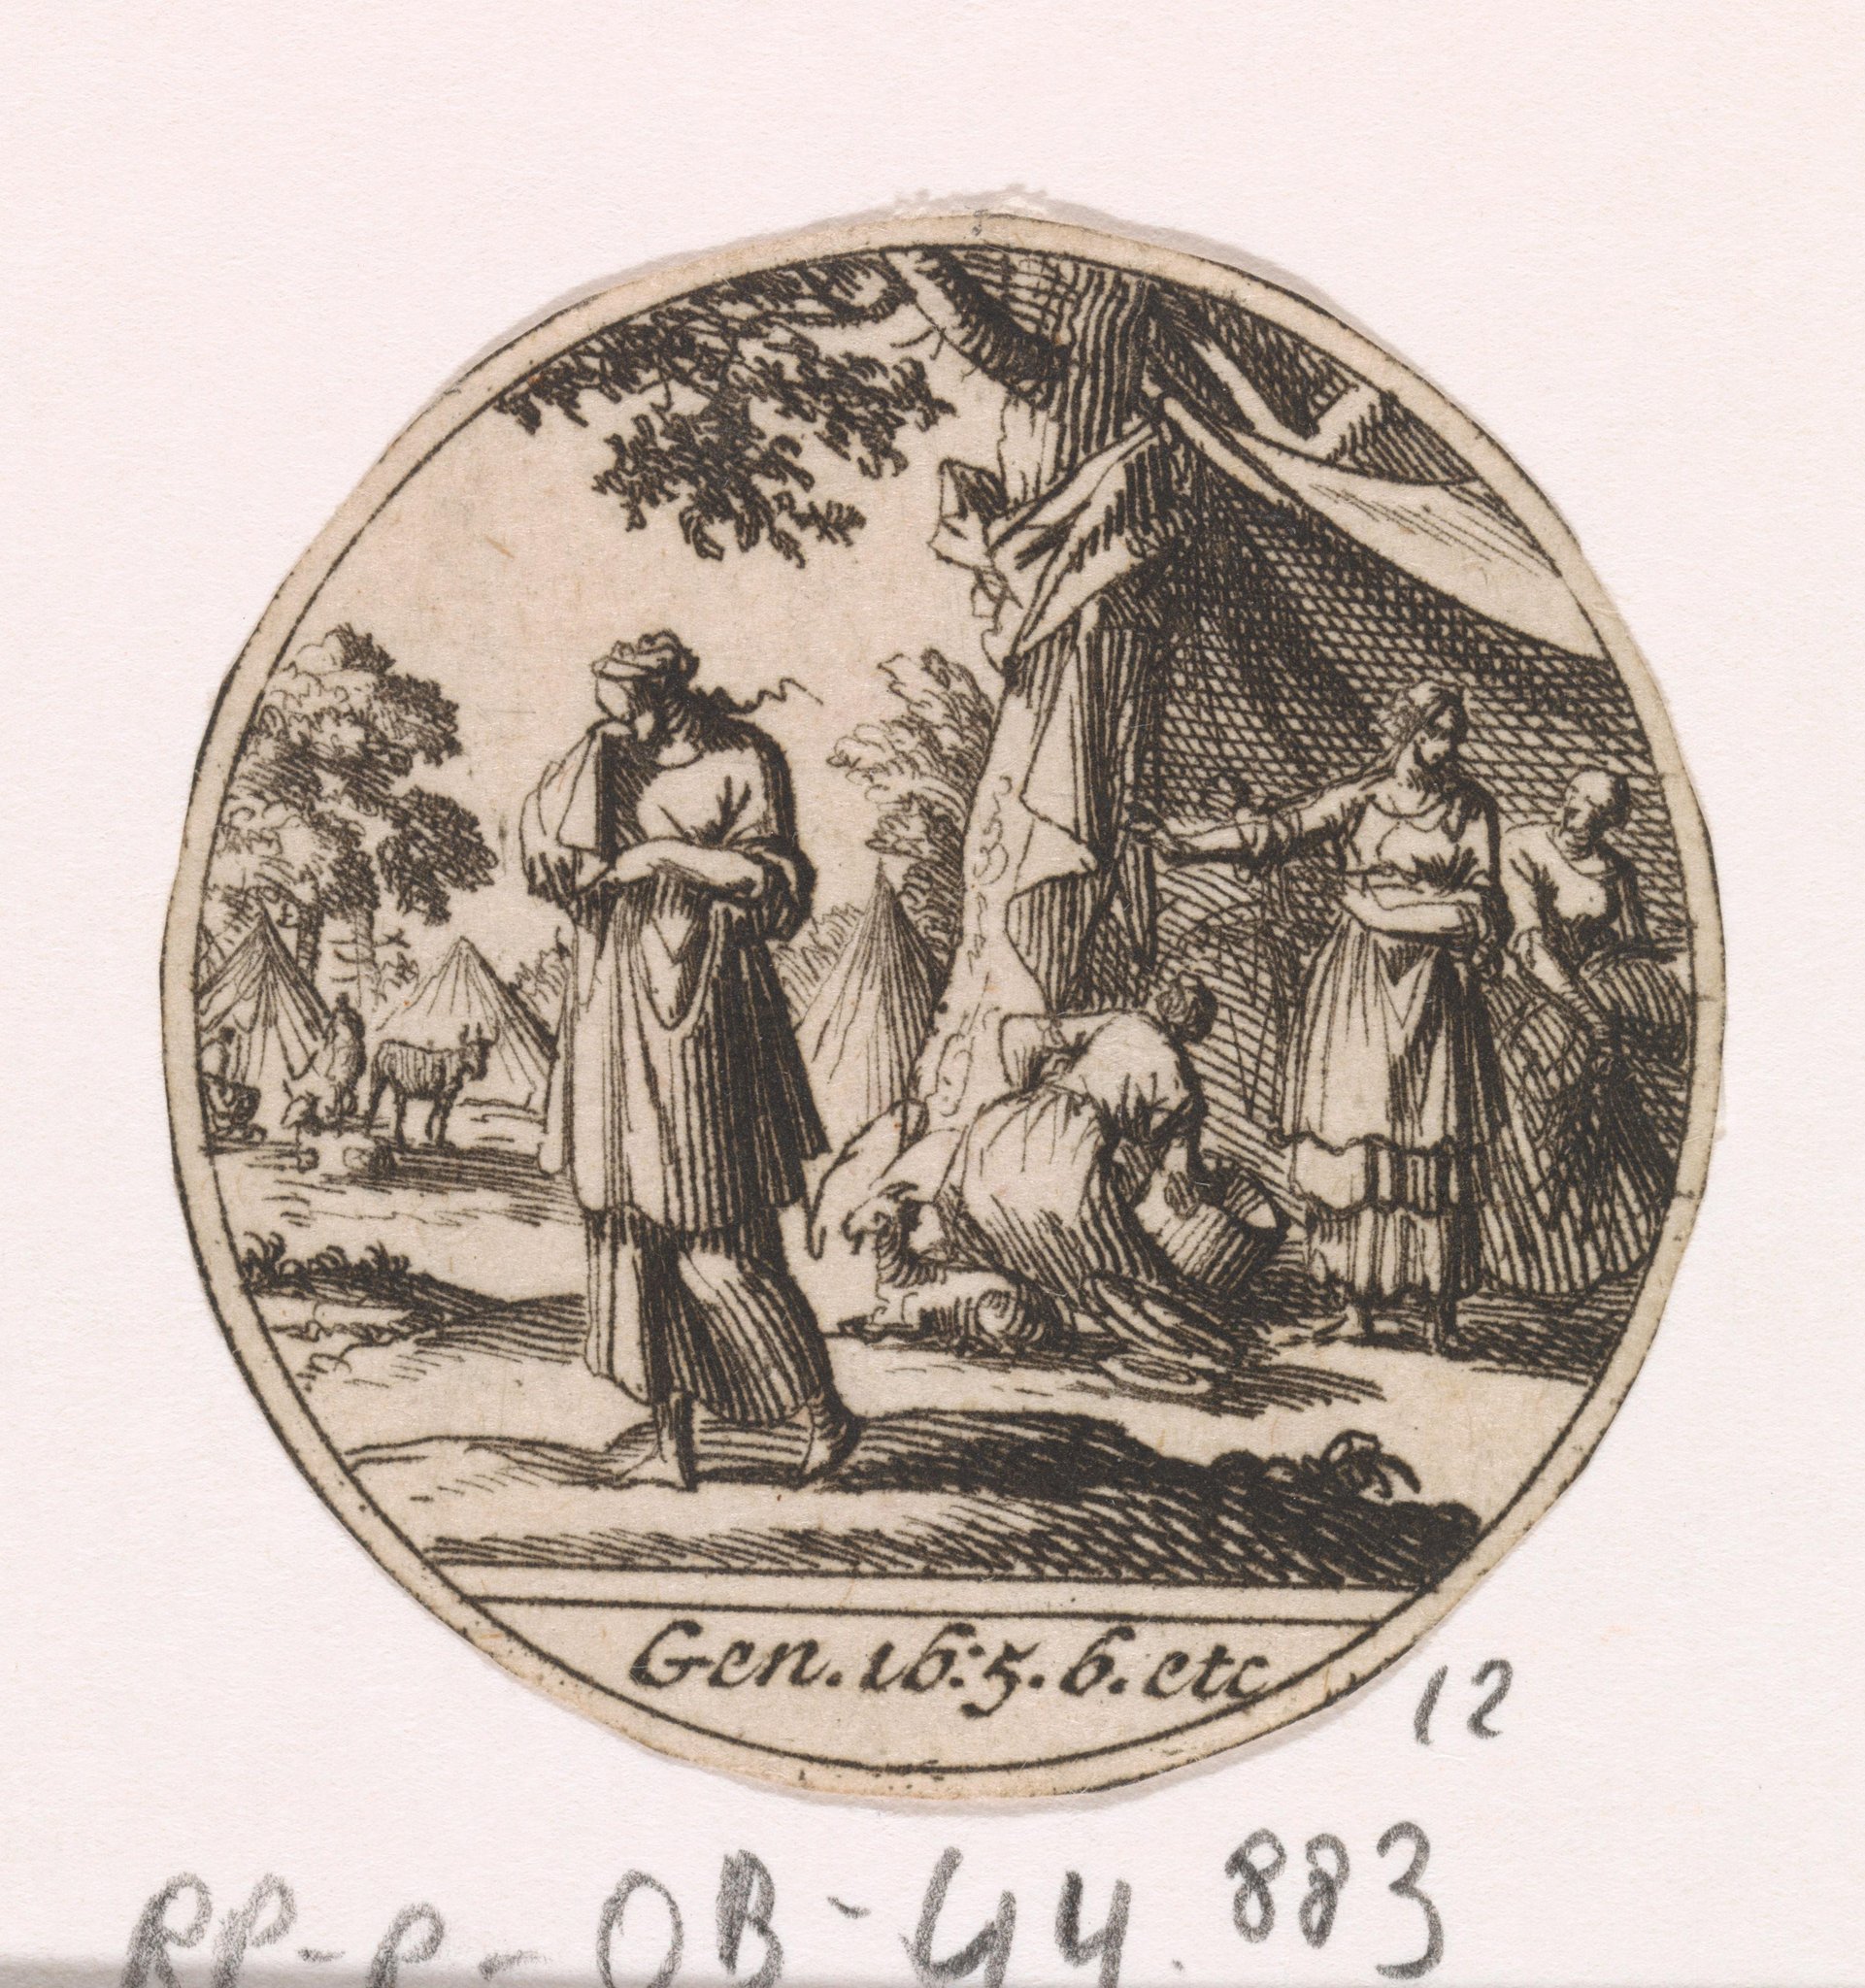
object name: print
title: Hagar wordt door Sara vernederd en vlucht weg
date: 1700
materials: paper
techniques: etching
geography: amsterdam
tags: hagar ill-treated by sarah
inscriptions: collector's mark: Lugt 240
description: Boekillustratie voor Willem Goeree. Mosaize historie der Hebreeuwse kerke. Amsterdam: Willem & David Goeree, 1700.